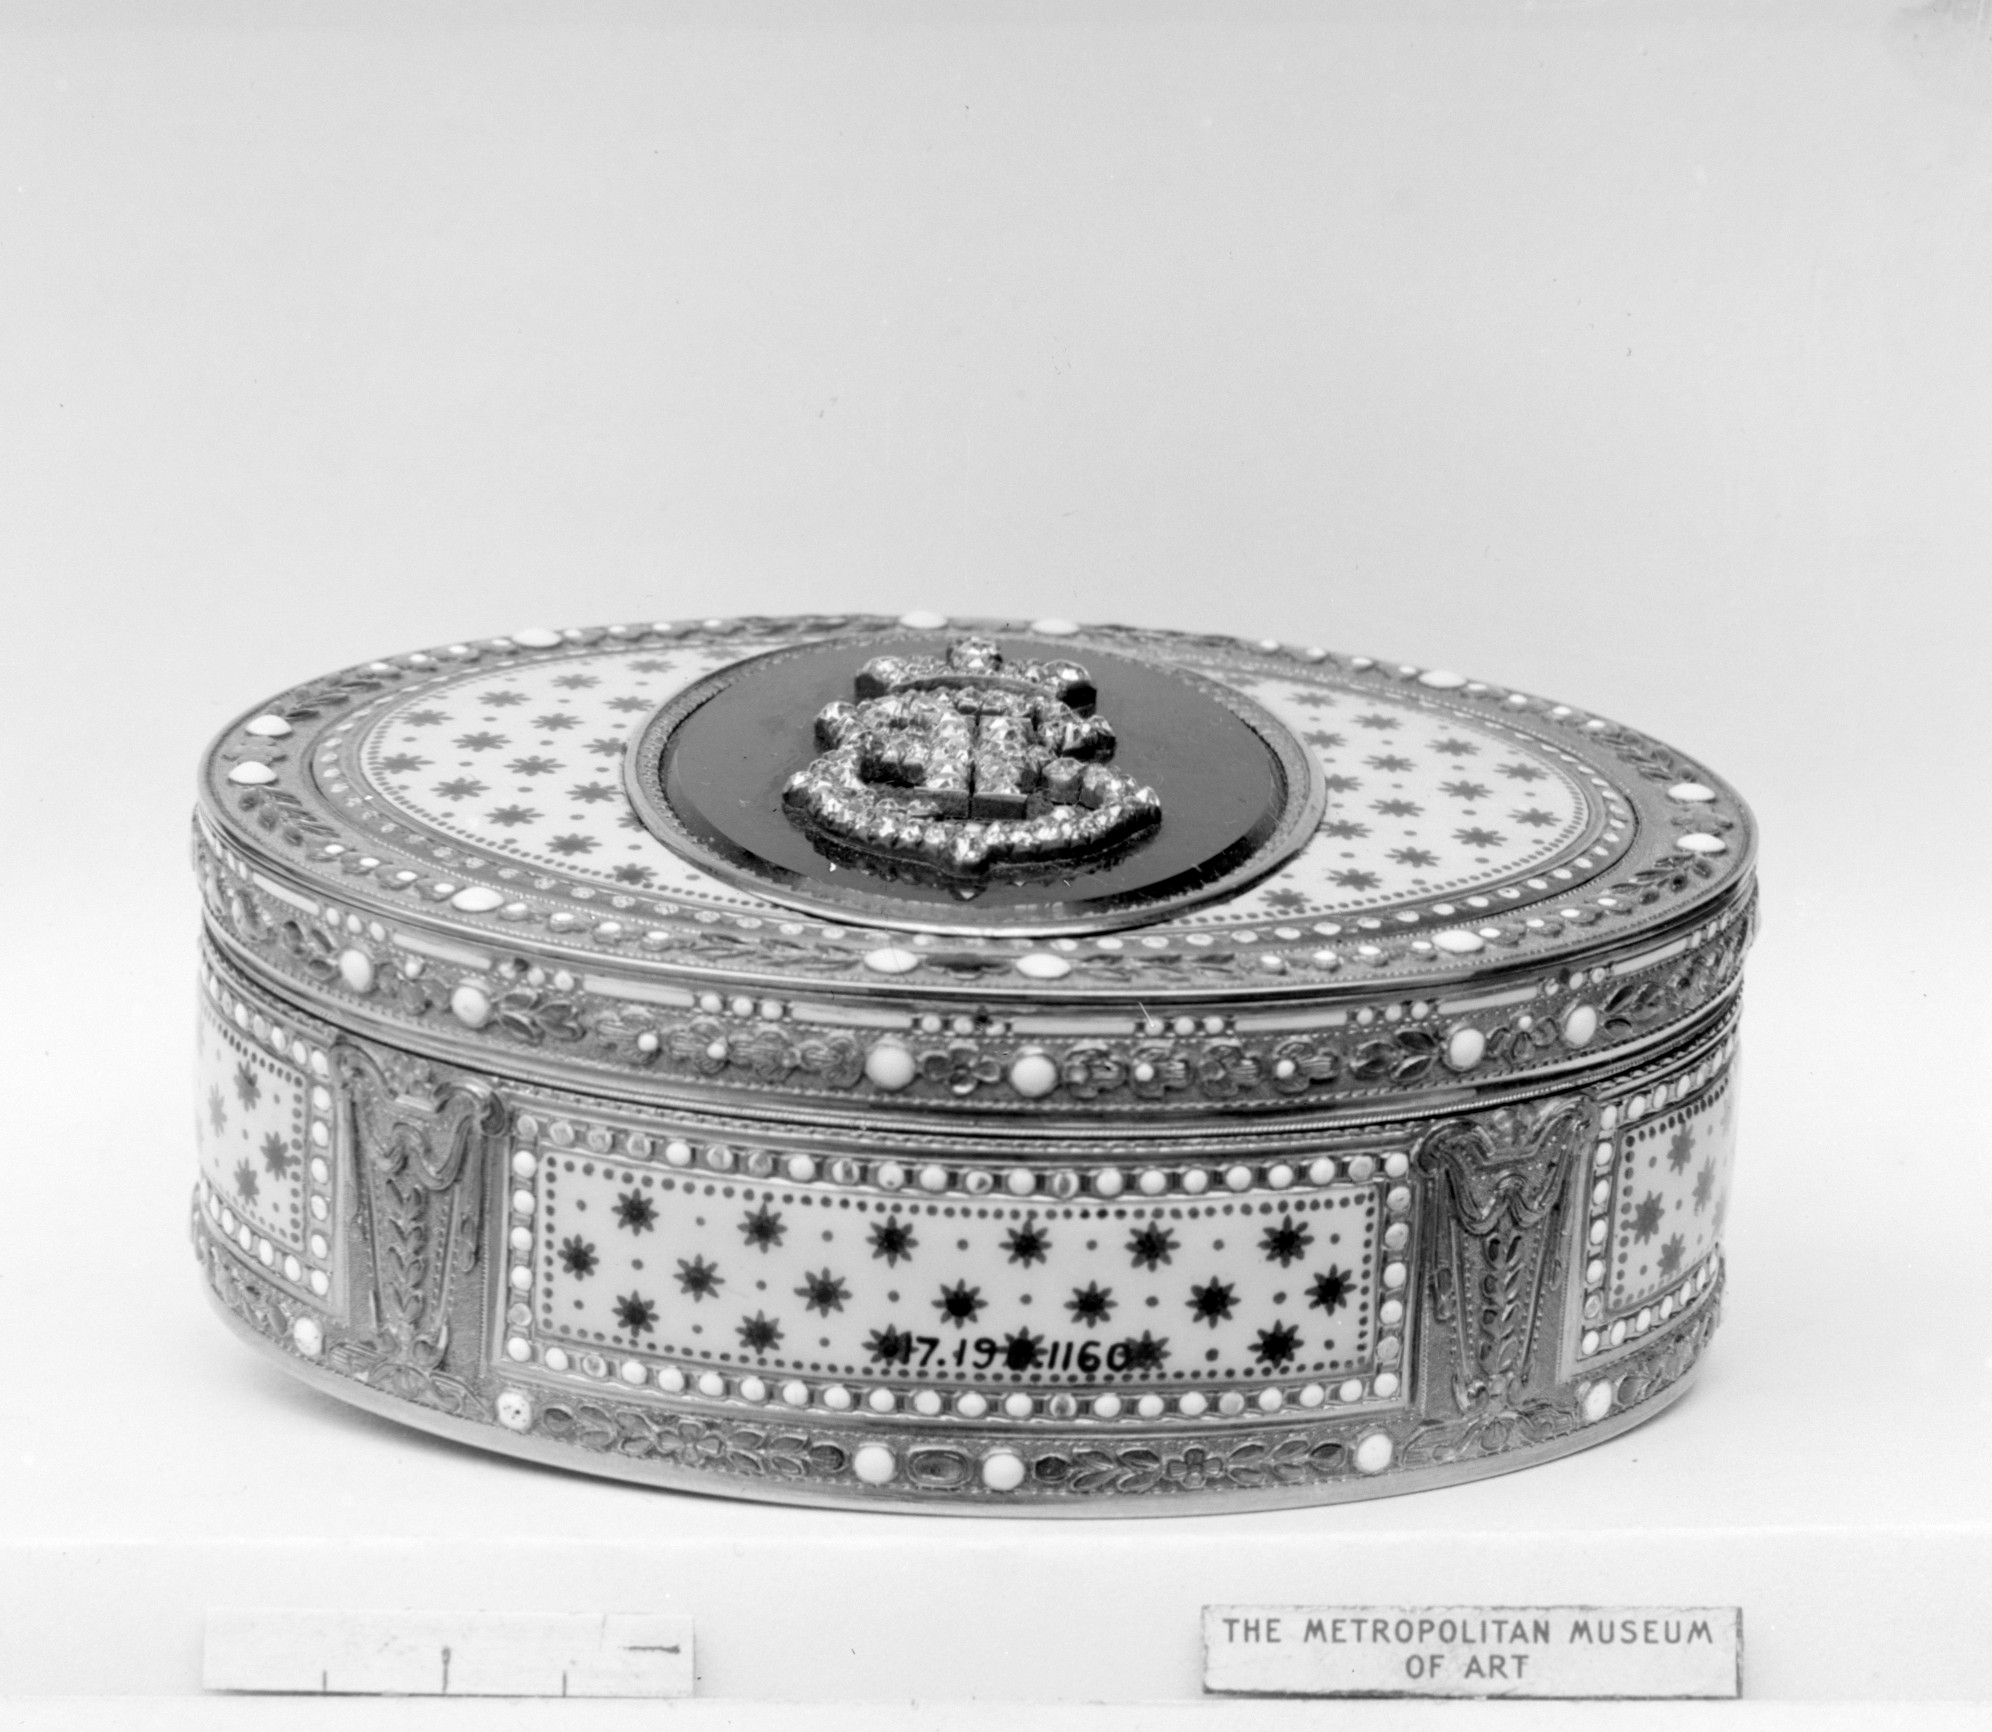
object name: snuffbox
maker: jean-joseph barrière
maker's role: maker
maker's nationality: french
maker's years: 1733-1833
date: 1782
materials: diamond, enamel, glass, gold